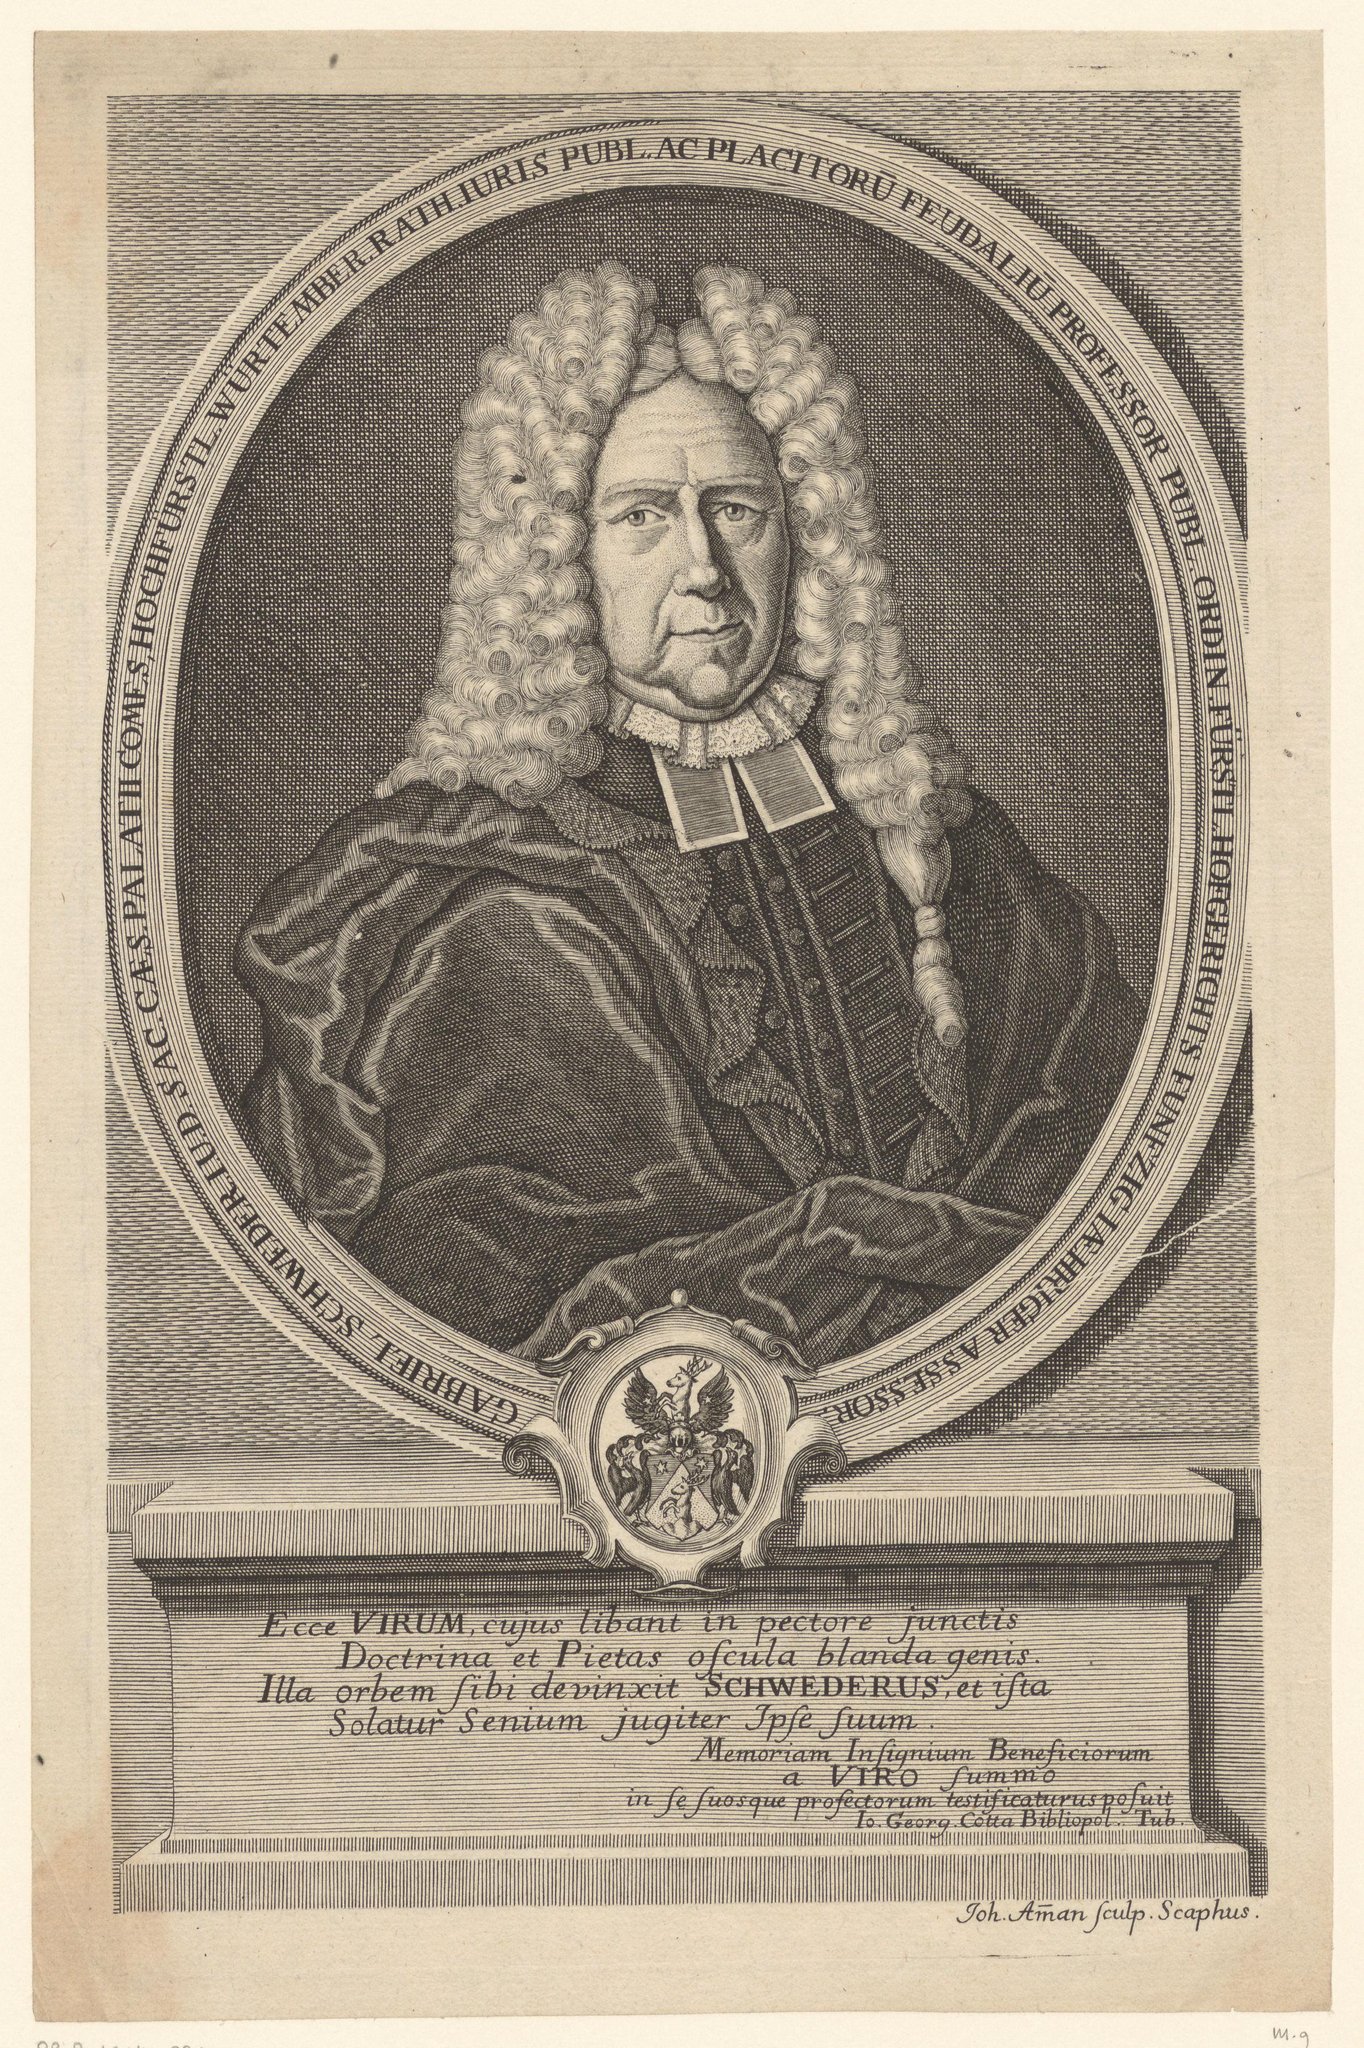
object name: print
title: Portret van Gabriel Schweder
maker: johannes ammann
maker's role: print maker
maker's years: 1695-1751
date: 1710-1751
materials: paper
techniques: engraving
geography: schaffhausen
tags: historical persons, armorial bearing, heraldry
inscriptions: collector's mark: Lugt 2228